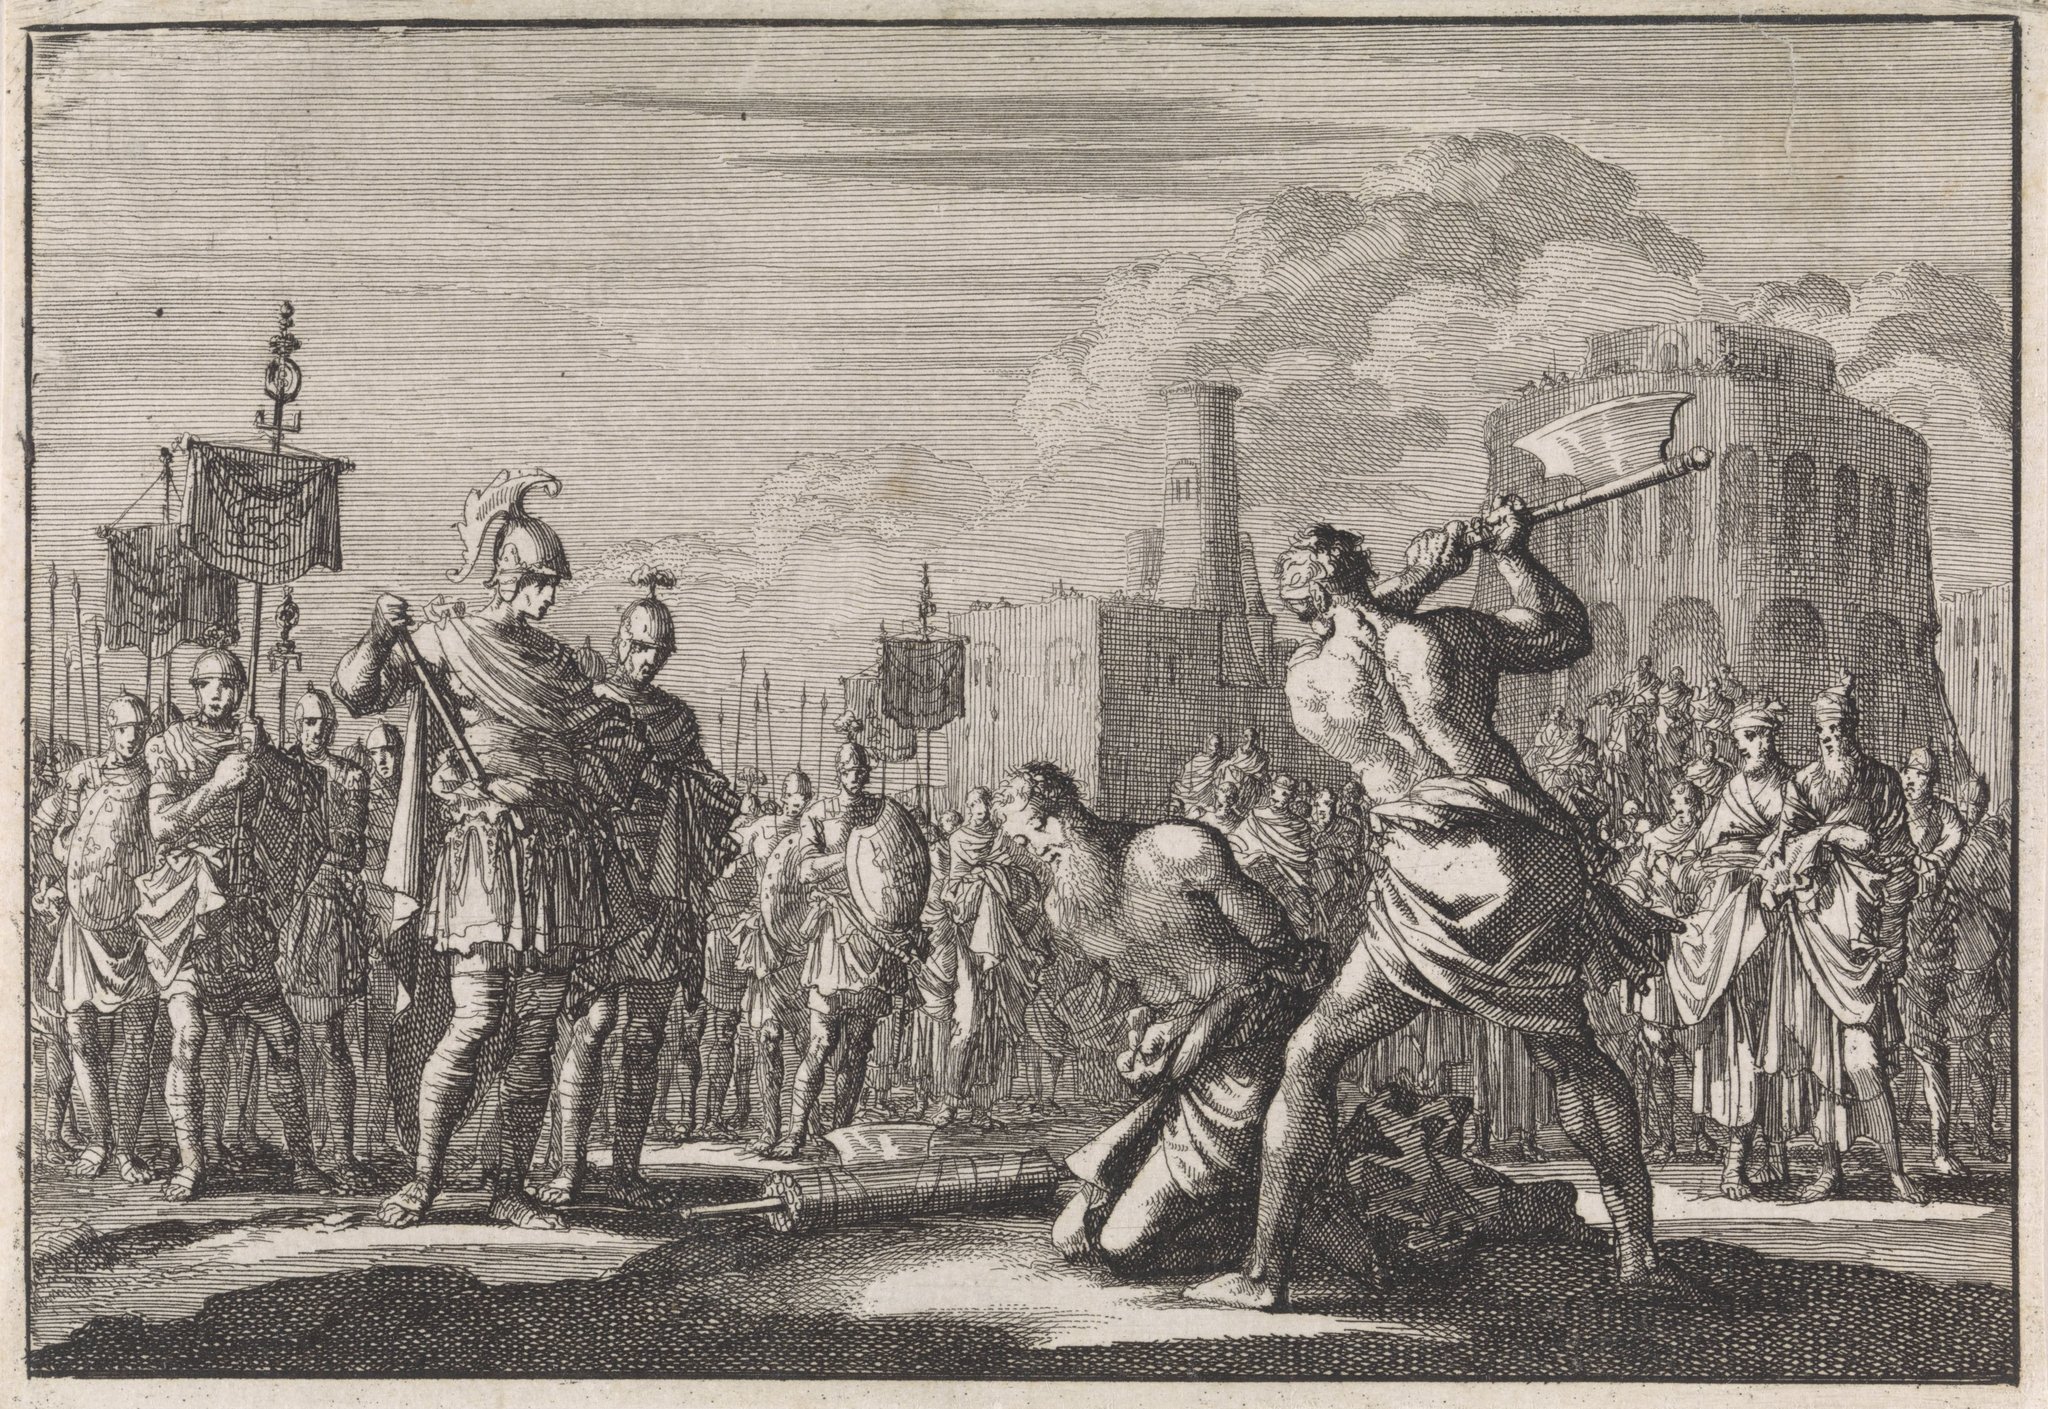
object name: print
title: Antigonus op bevel van Antonius onthoofd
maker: jan luyken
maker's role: draughtsman, print maker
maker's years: 1649-1712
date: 1704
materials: paper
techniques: etching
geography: amsterdam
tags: violent death by beheading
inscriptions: collector's mark: Lugt 2228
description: Prent ook gebruikt als boekillustratie in: Josephus, Flavius. Alle de Werken, 2 delen. Amsterdam: Pieter Mortier, 1704, dl. 1, p. 359.